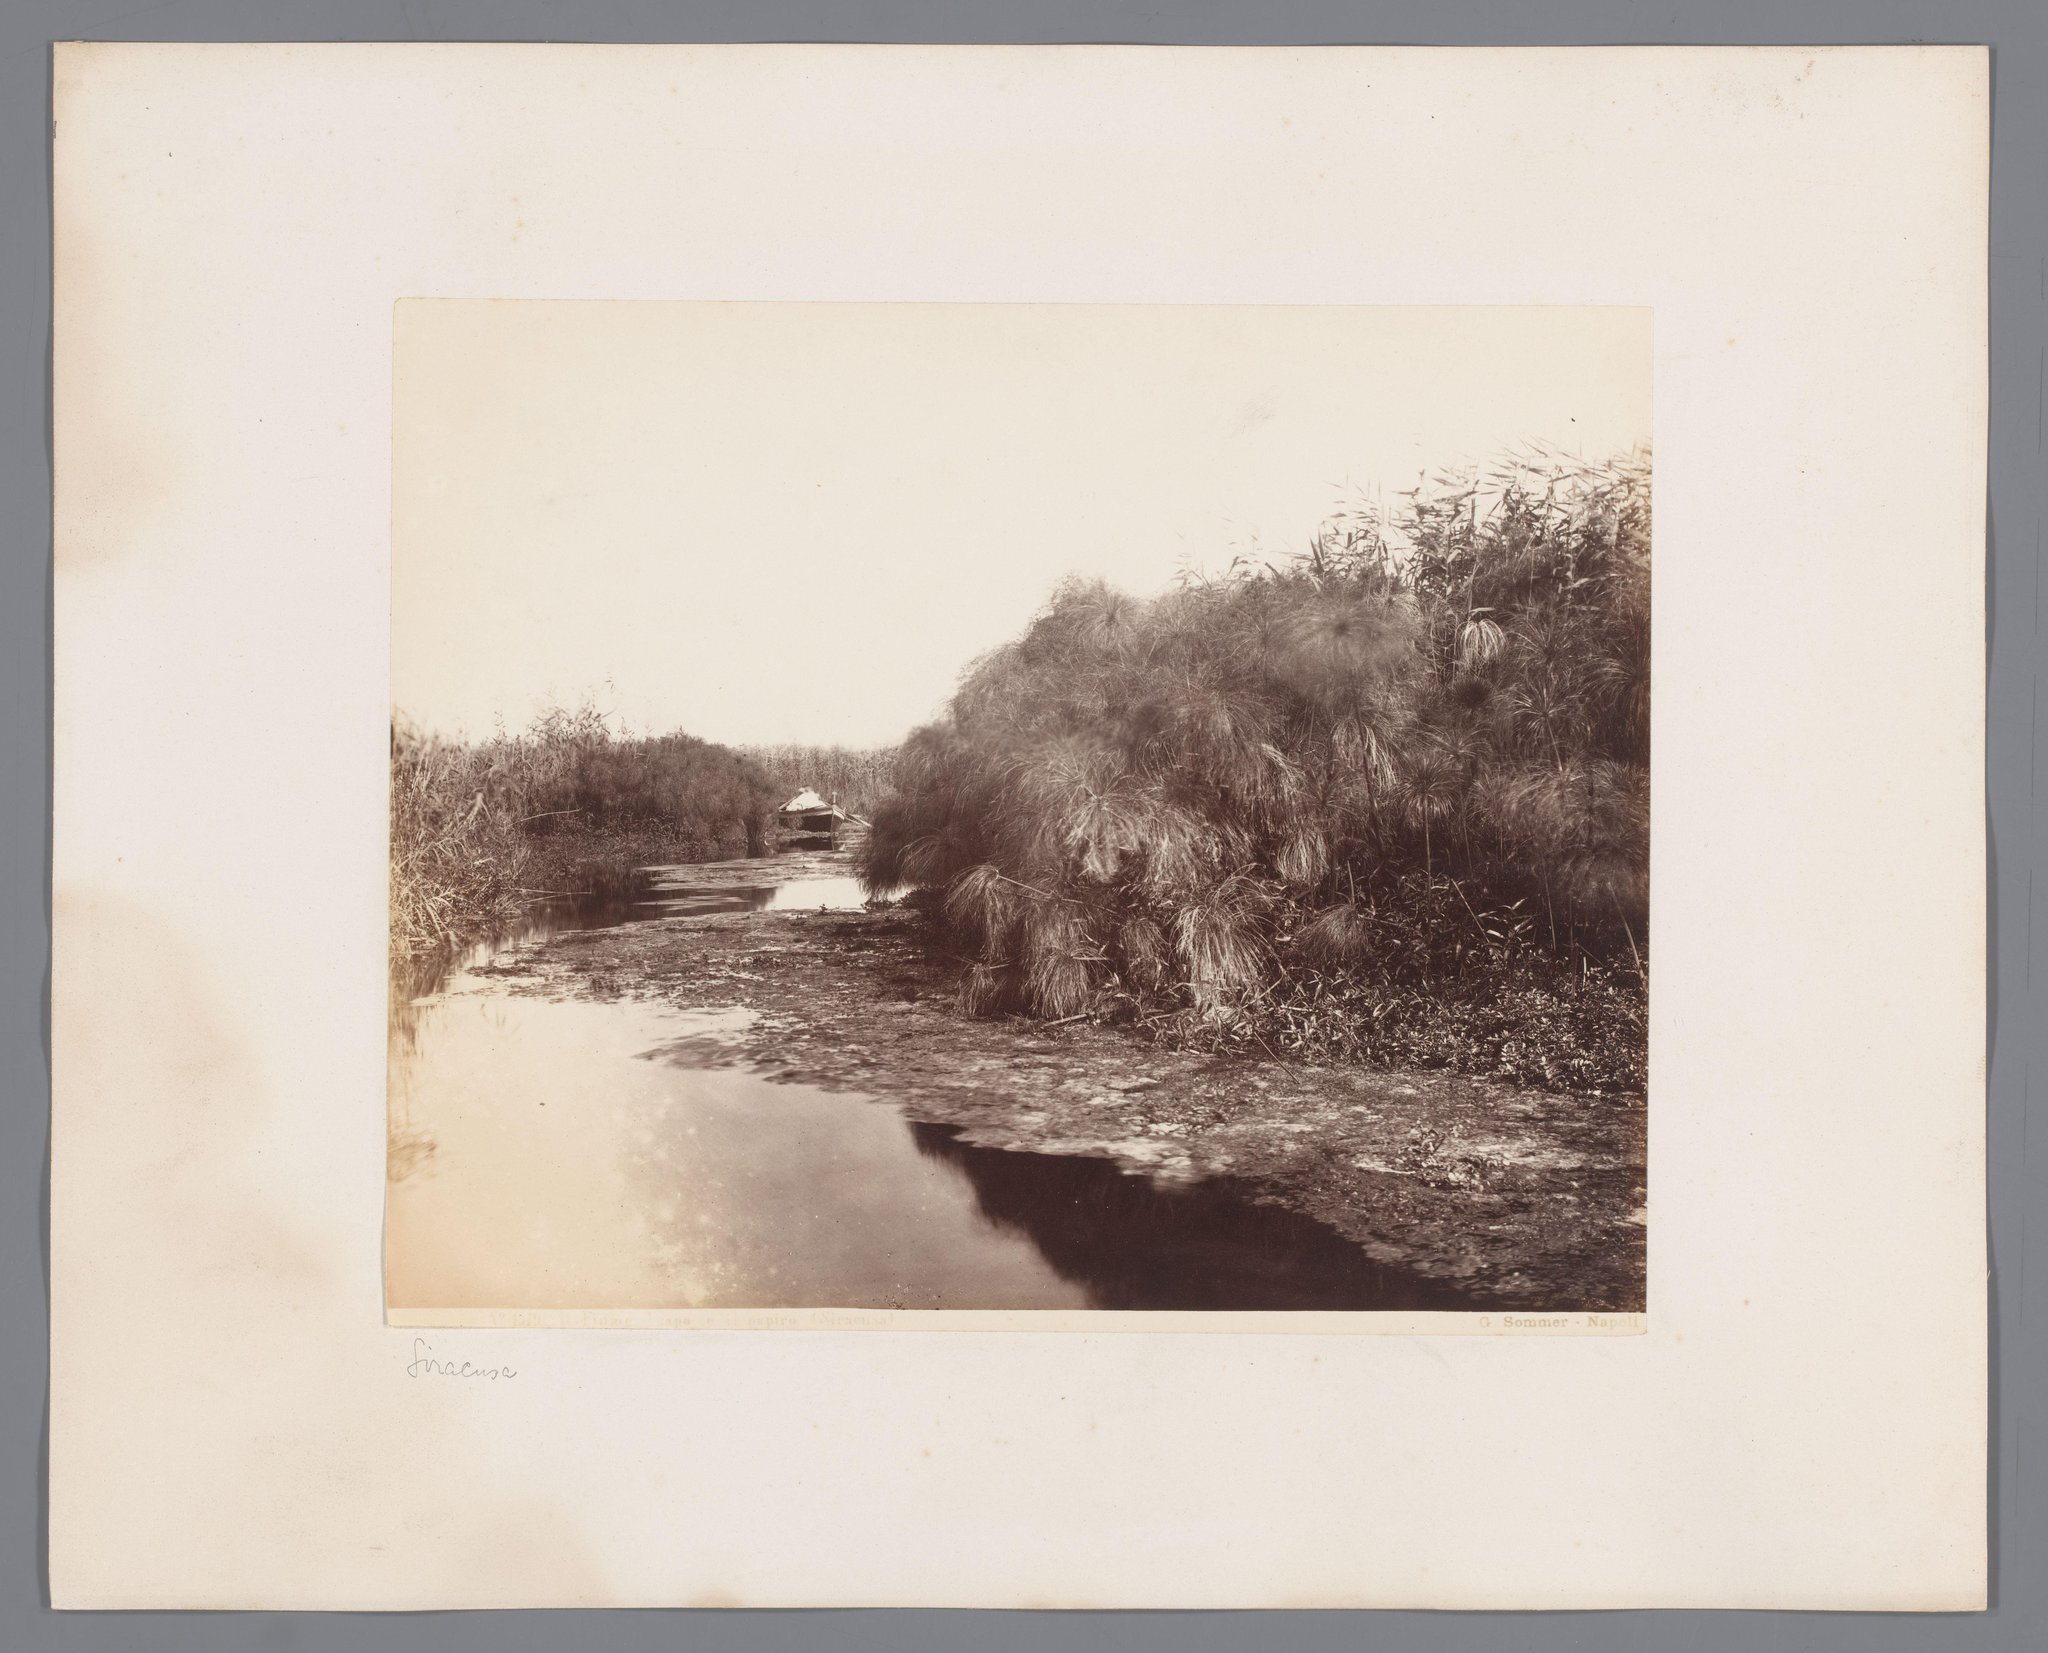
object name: photograph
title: Il Fiume Anapo e il papiro (Siracusa)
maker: giorgio sommer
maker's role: fotograaf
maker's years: 1834-1914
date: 1857-1914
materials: cardboard, paper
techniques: albumen print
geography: syracuse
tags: plants; vegetation, river, rowing-boat, canoe, etc.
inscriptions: number: ‘No. 1579’, inscription: ‘Siracuse’